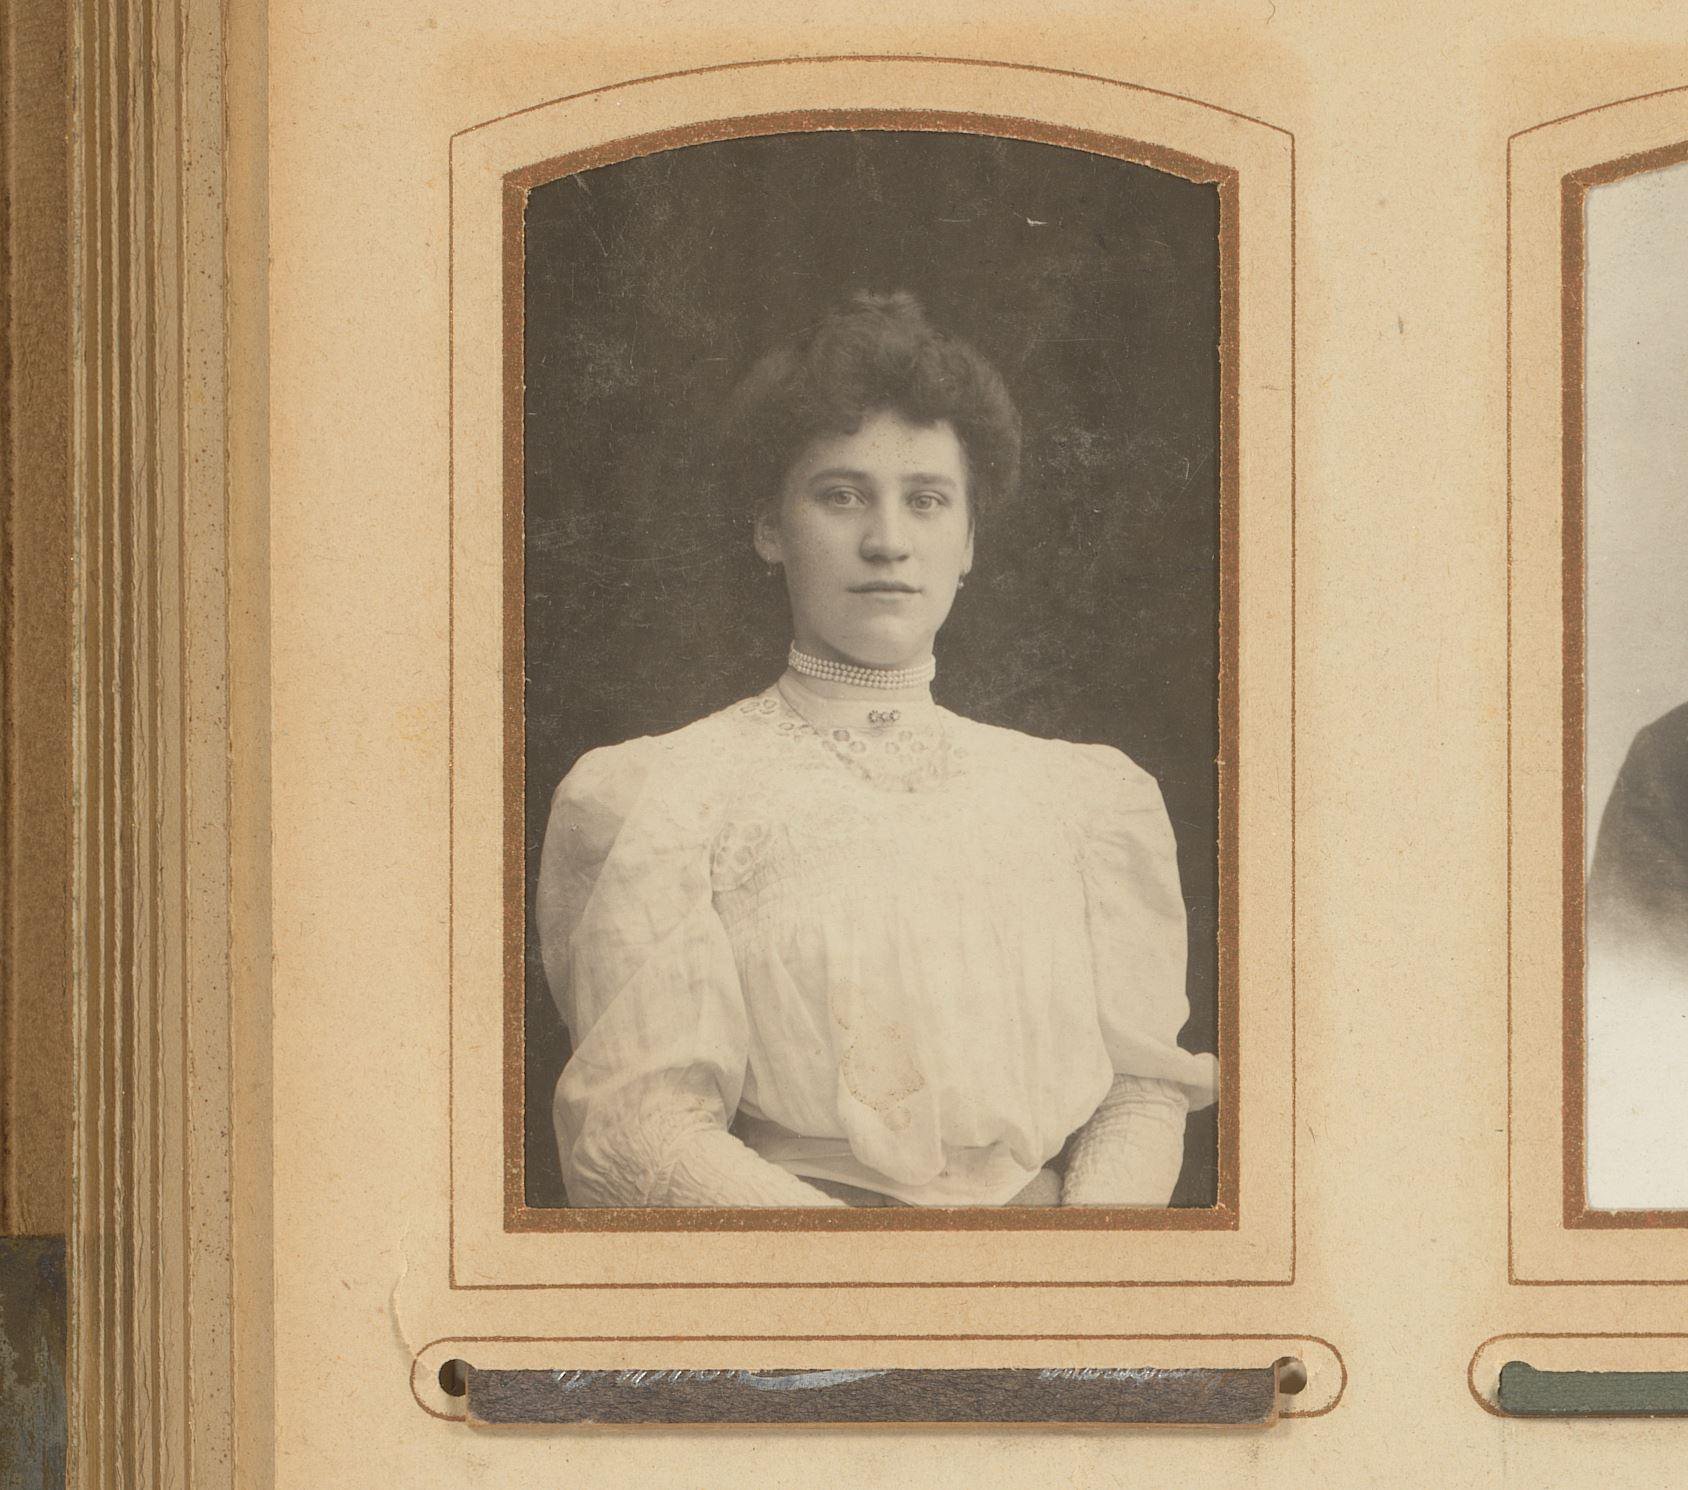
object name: carte de visite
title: Portret van een vrouw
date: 1901-1920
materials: cardboard, photographic support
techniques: collodion silver print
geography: utrecht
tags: historical persons - bb - woman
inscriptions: inscription: ‘Gysi & Co./ Aarau’, date: ‘1903’, inscription: ‘Vergrosserungs - Anstalt/ Gysi & Co/ Phot. Artistisches Atelier/ Aarau’, number: ‘70216’